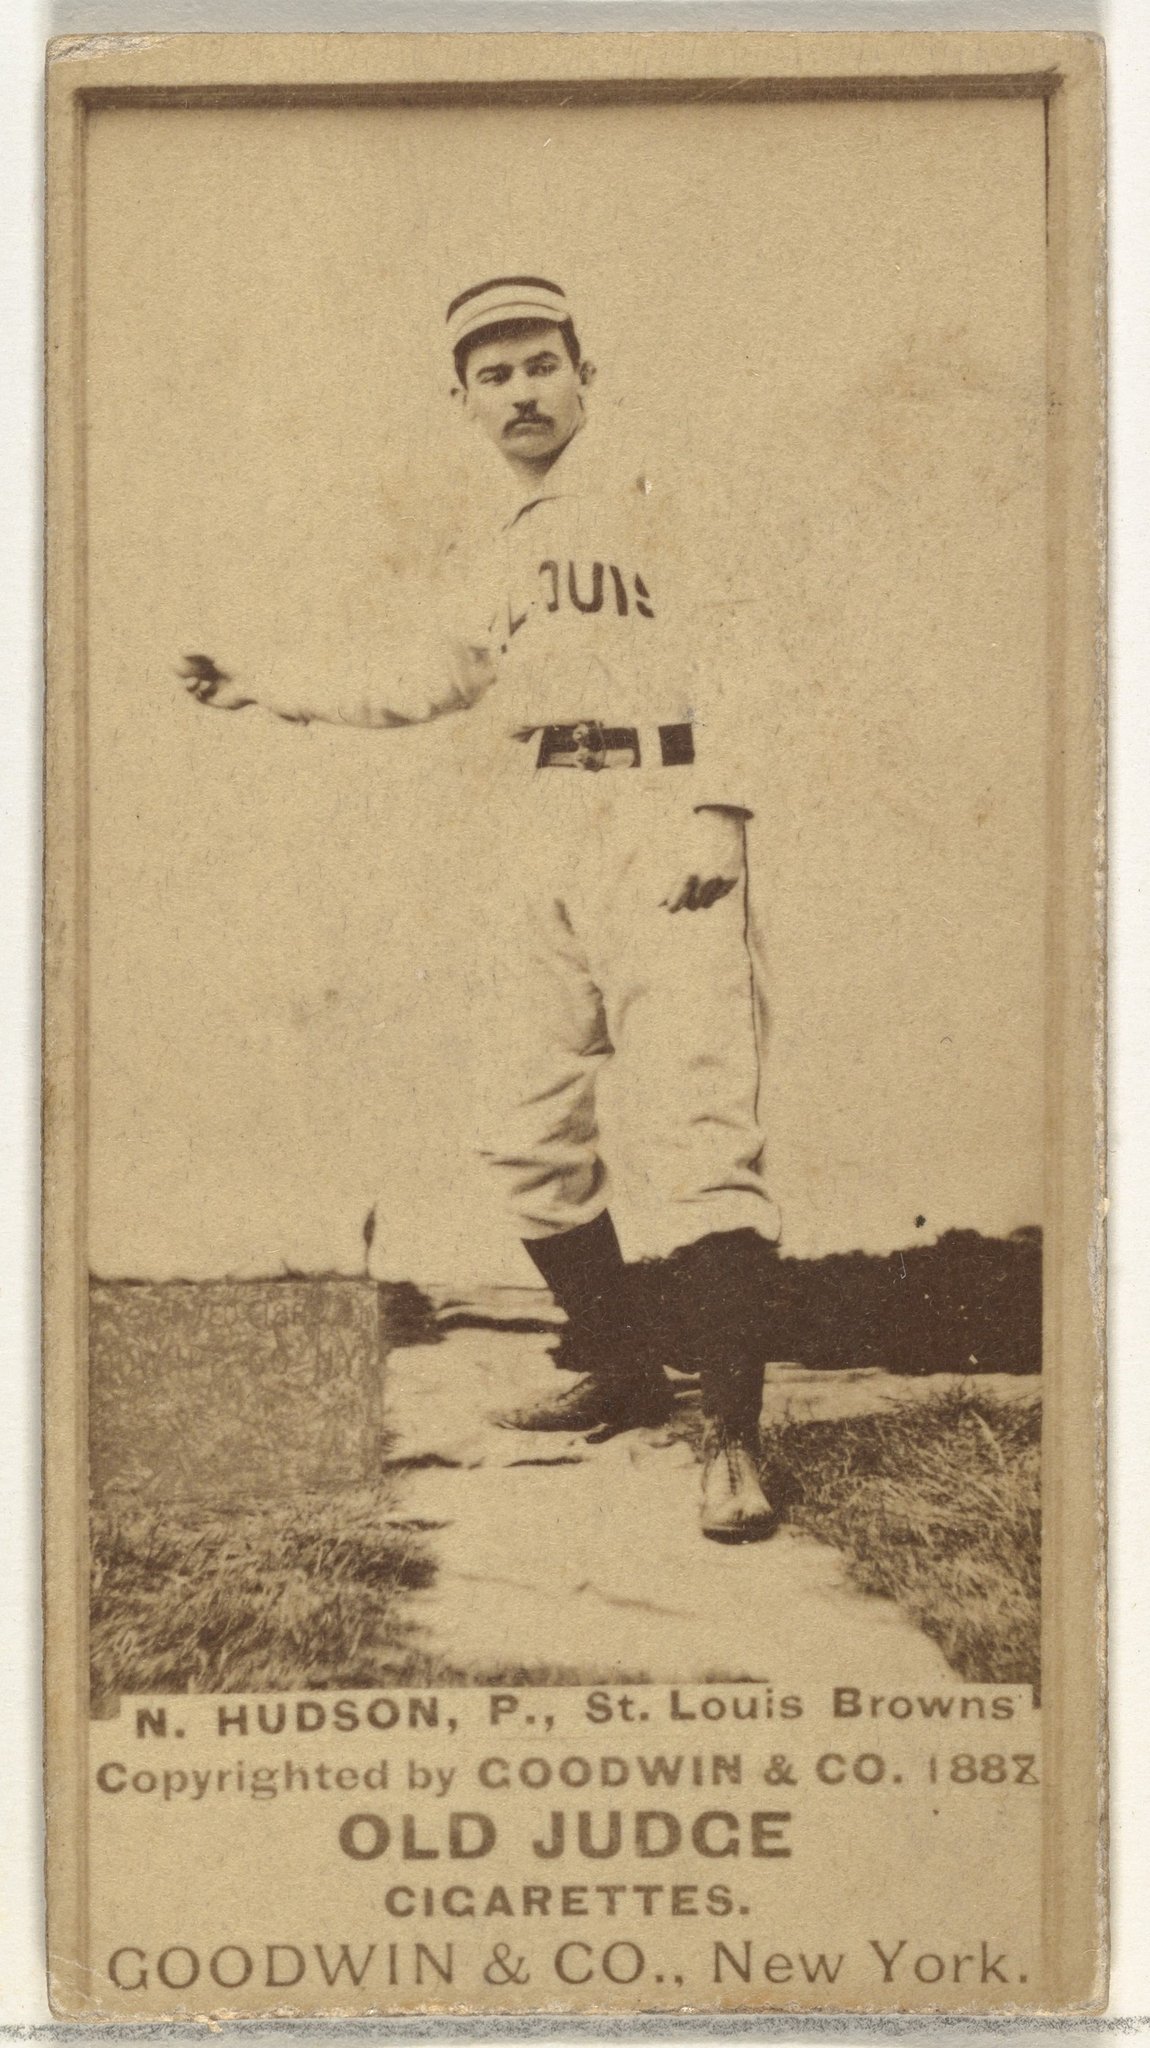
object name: baseball card, photograph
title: Nathaniel P. "Nat" Hudson, Pitcher, St. Louis Browns, from the Old Judge series (N172) for Old Judge Cigarettes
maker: goodwin & company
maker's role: publisher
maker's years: 1850-1950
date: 1888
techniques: albumen silver print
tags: men,portraits,baseball,athletes